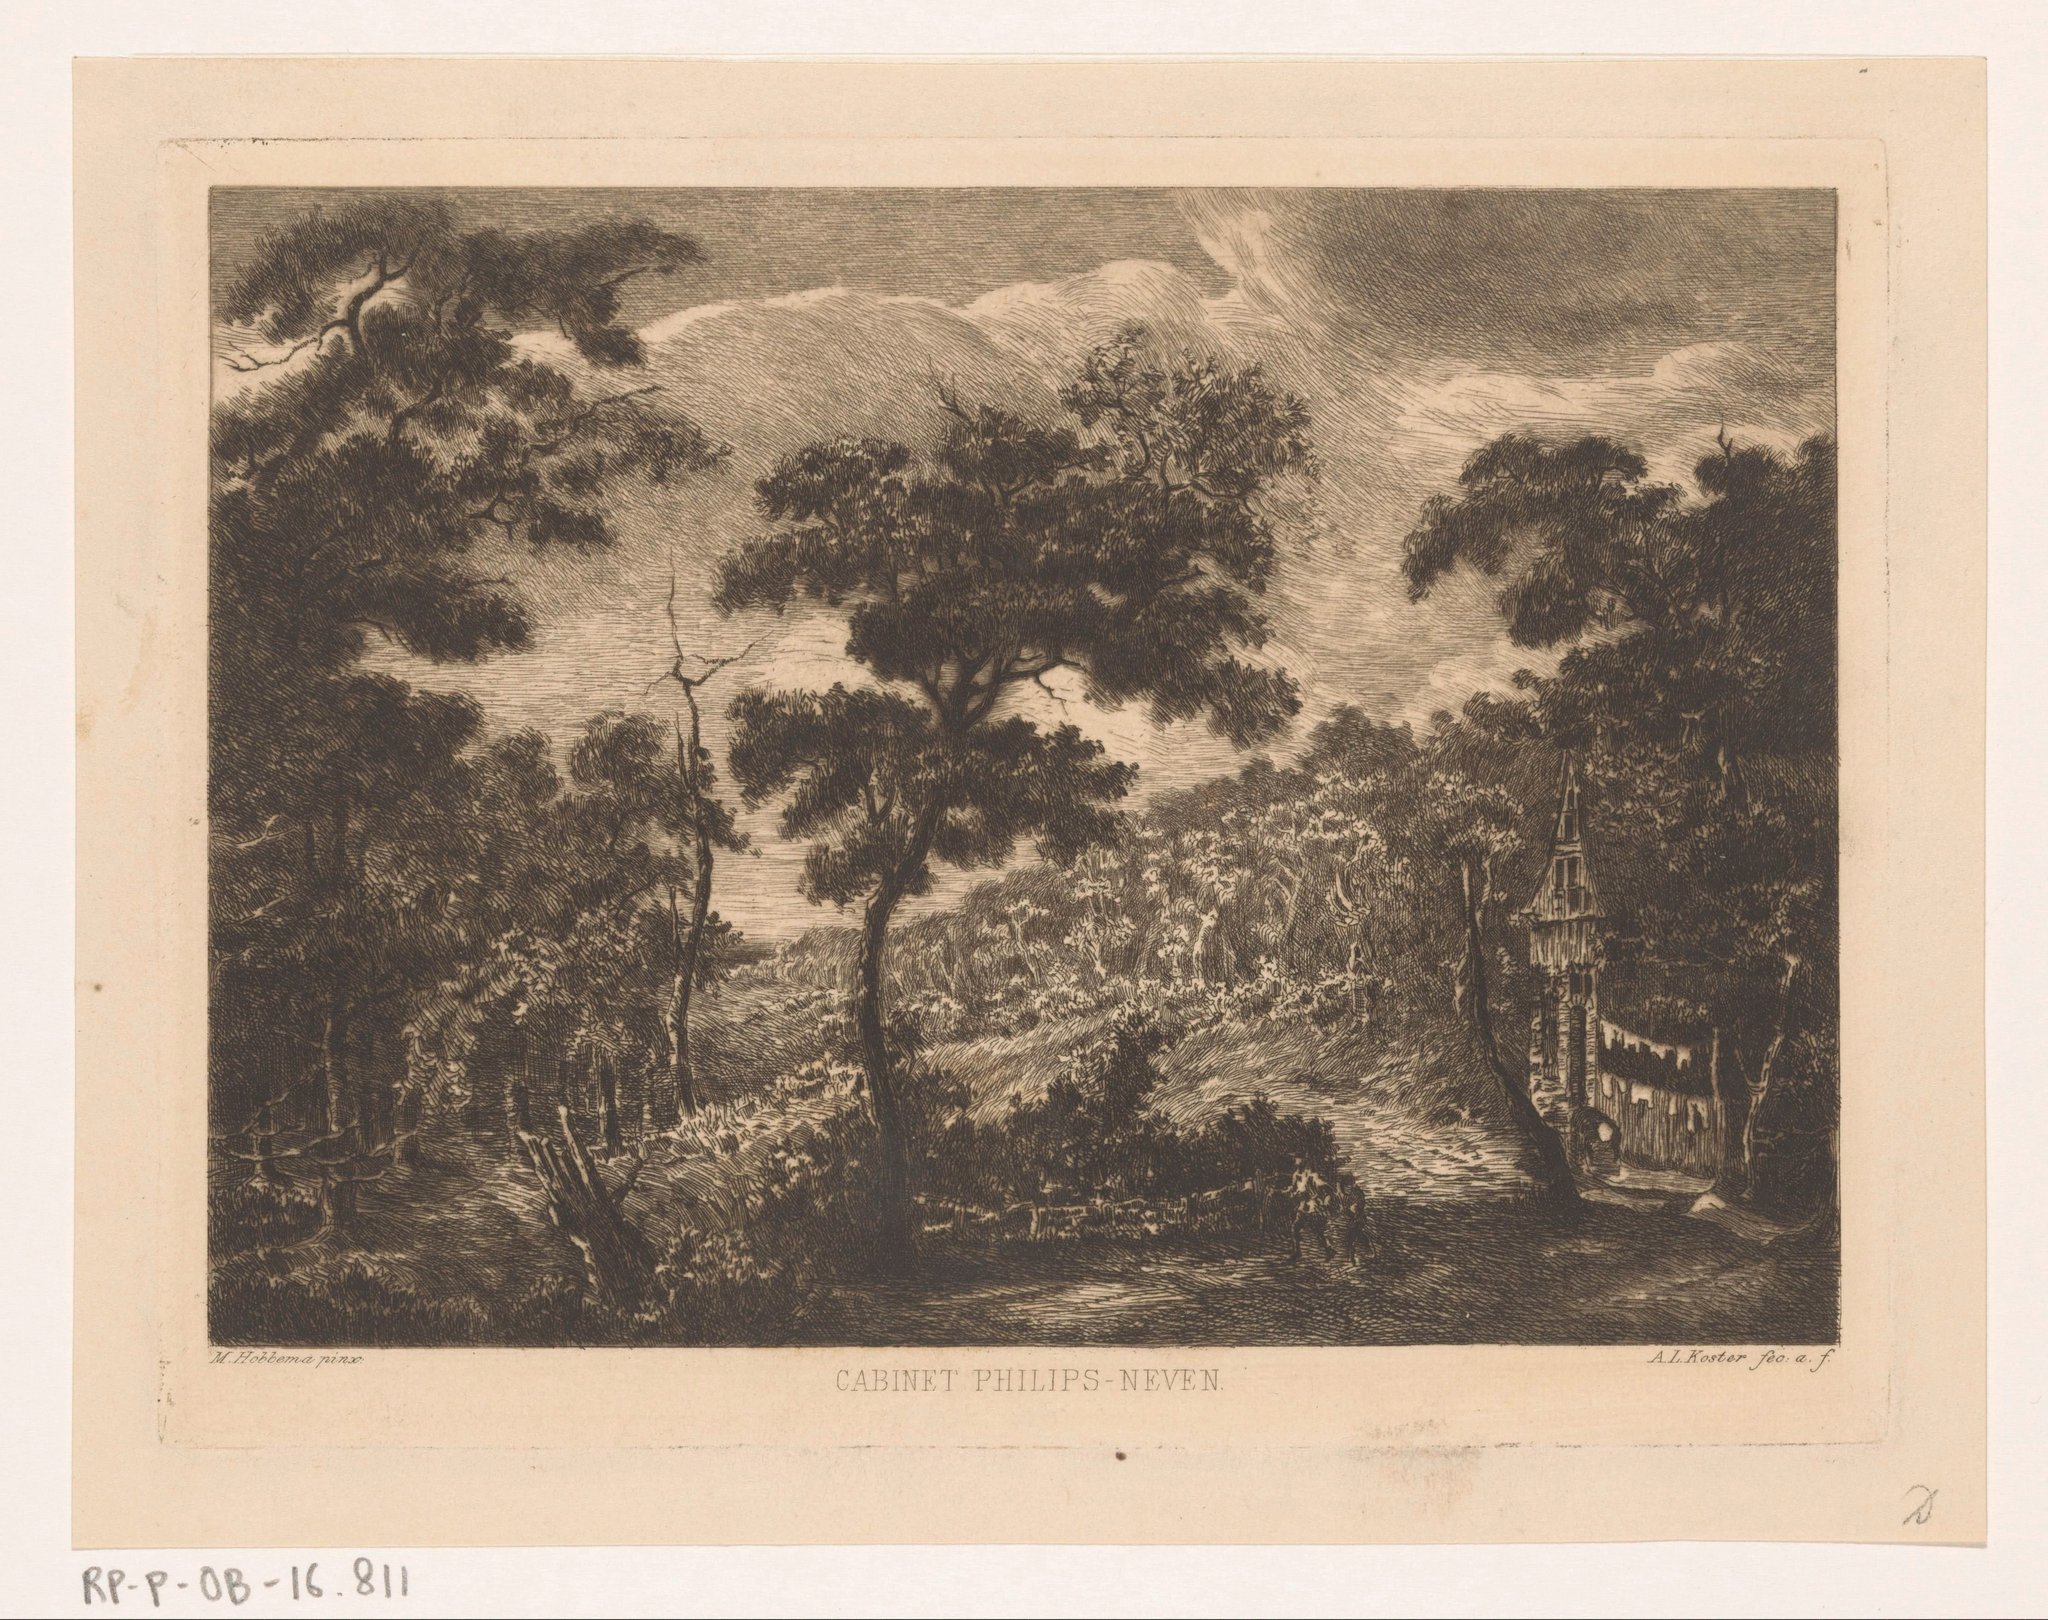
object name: print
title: Heuvellandschap met bos en houten huis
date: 1869-1937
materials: paper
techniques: etching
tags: low hill country, forest, wood, farm or solitary house in landscape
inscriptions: collector's mark: Lugt 2228, inscription: ‘Cabinet Philips-Neven’, collector's mark: Lugt 2760